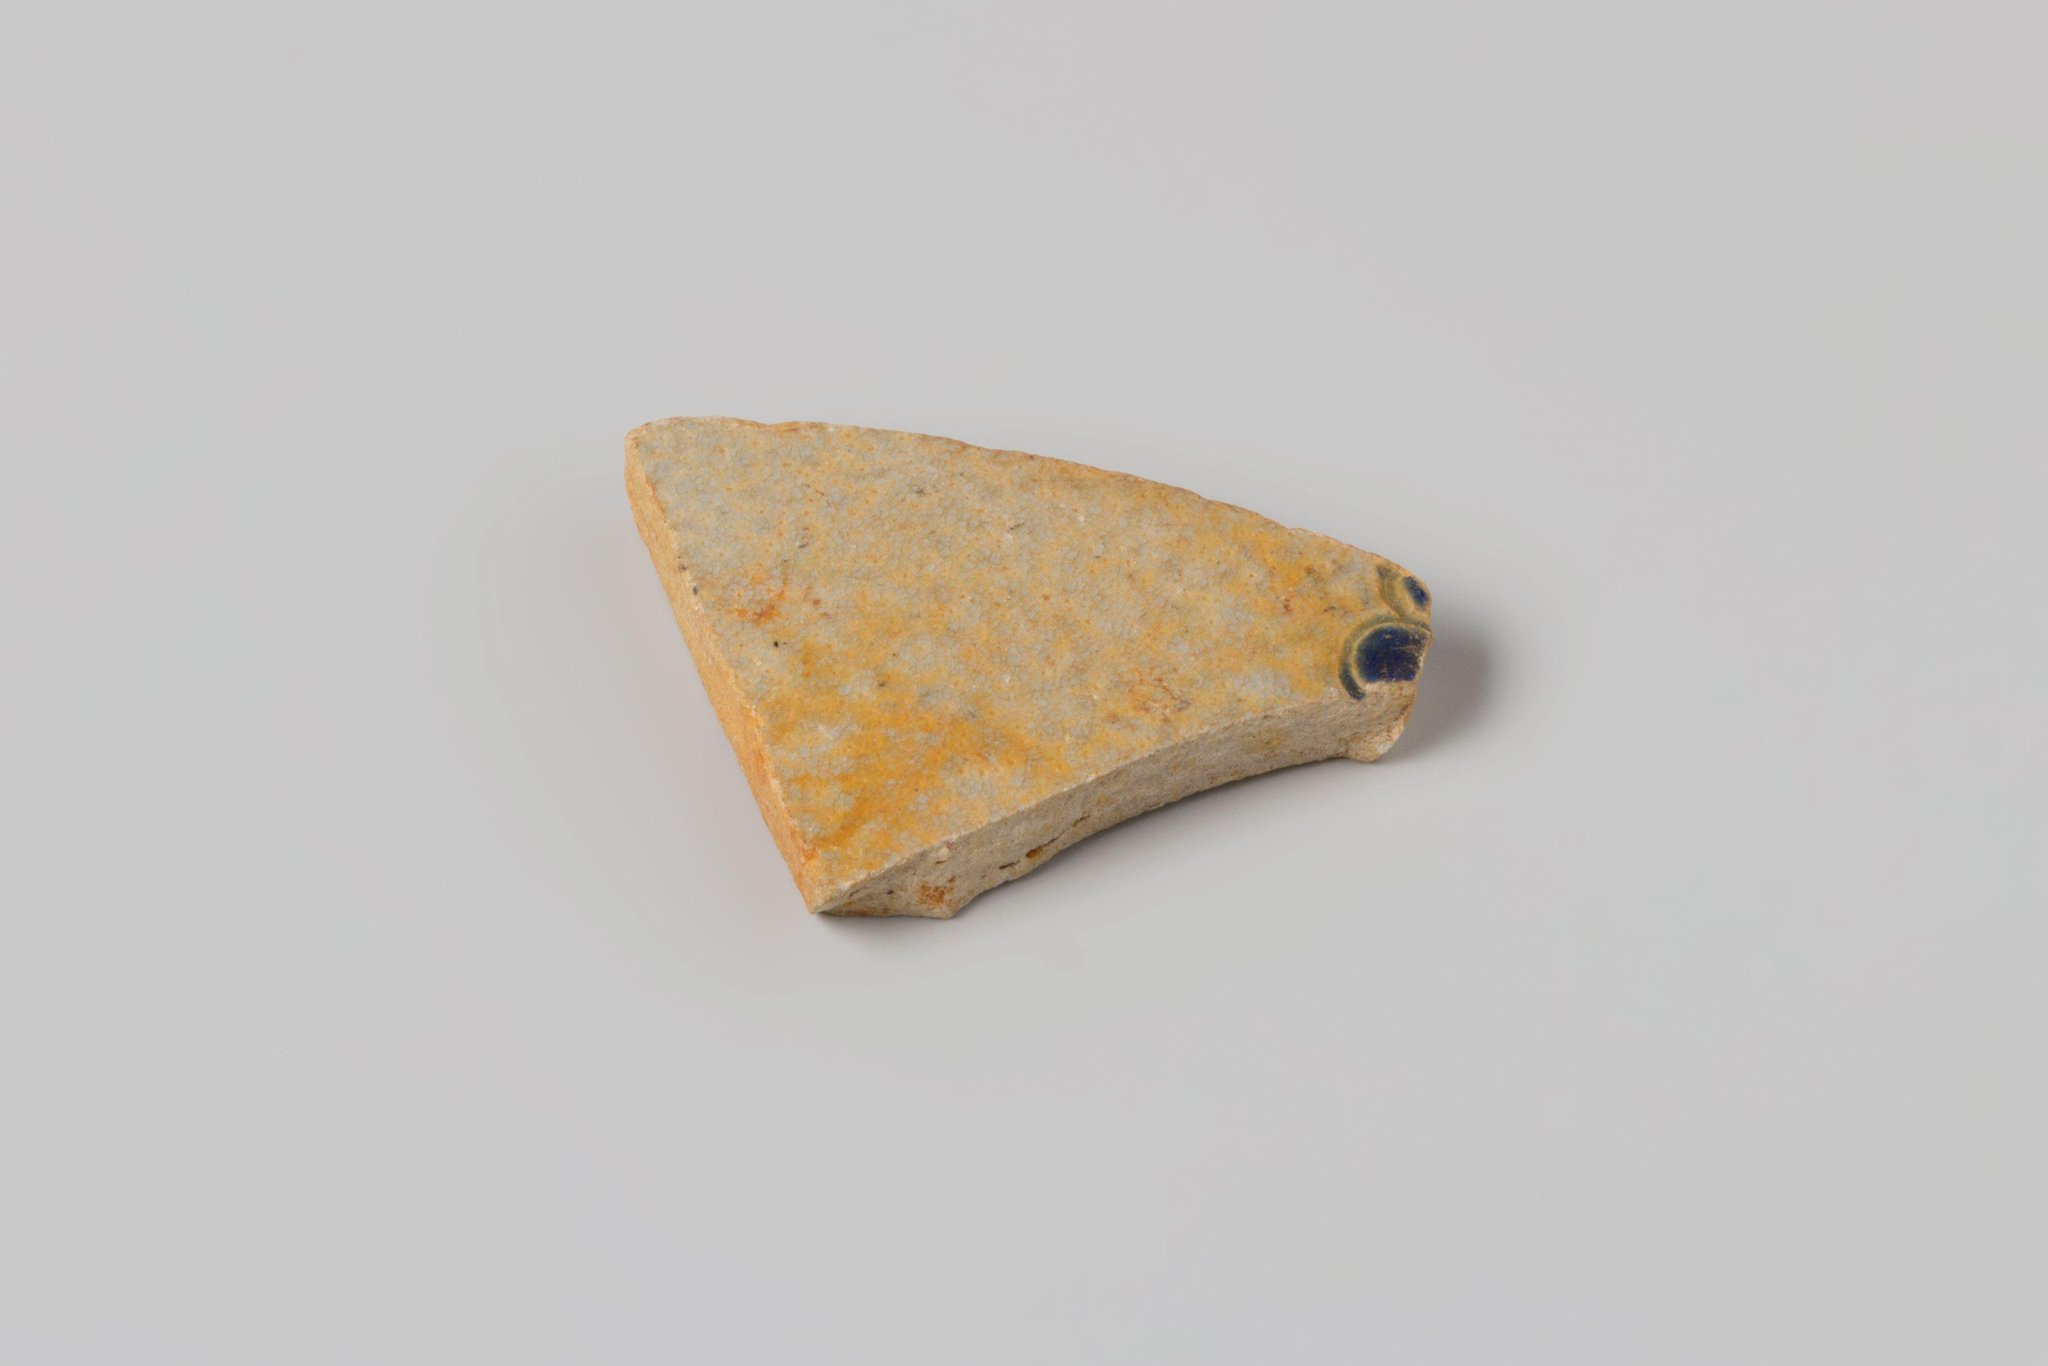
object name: pot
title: Scherf van een pot uit het wrak van de Oost-Indiëvaarder Hollandia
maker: Anonymous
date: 1700-1743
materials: stoneware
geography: westerwald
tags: verenigde oostindische compagnie, hollandia (schip), annet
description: Stoneware, Rhenish, Westerwald, pot; of base and body, sim. NG 1980-27H2624r.